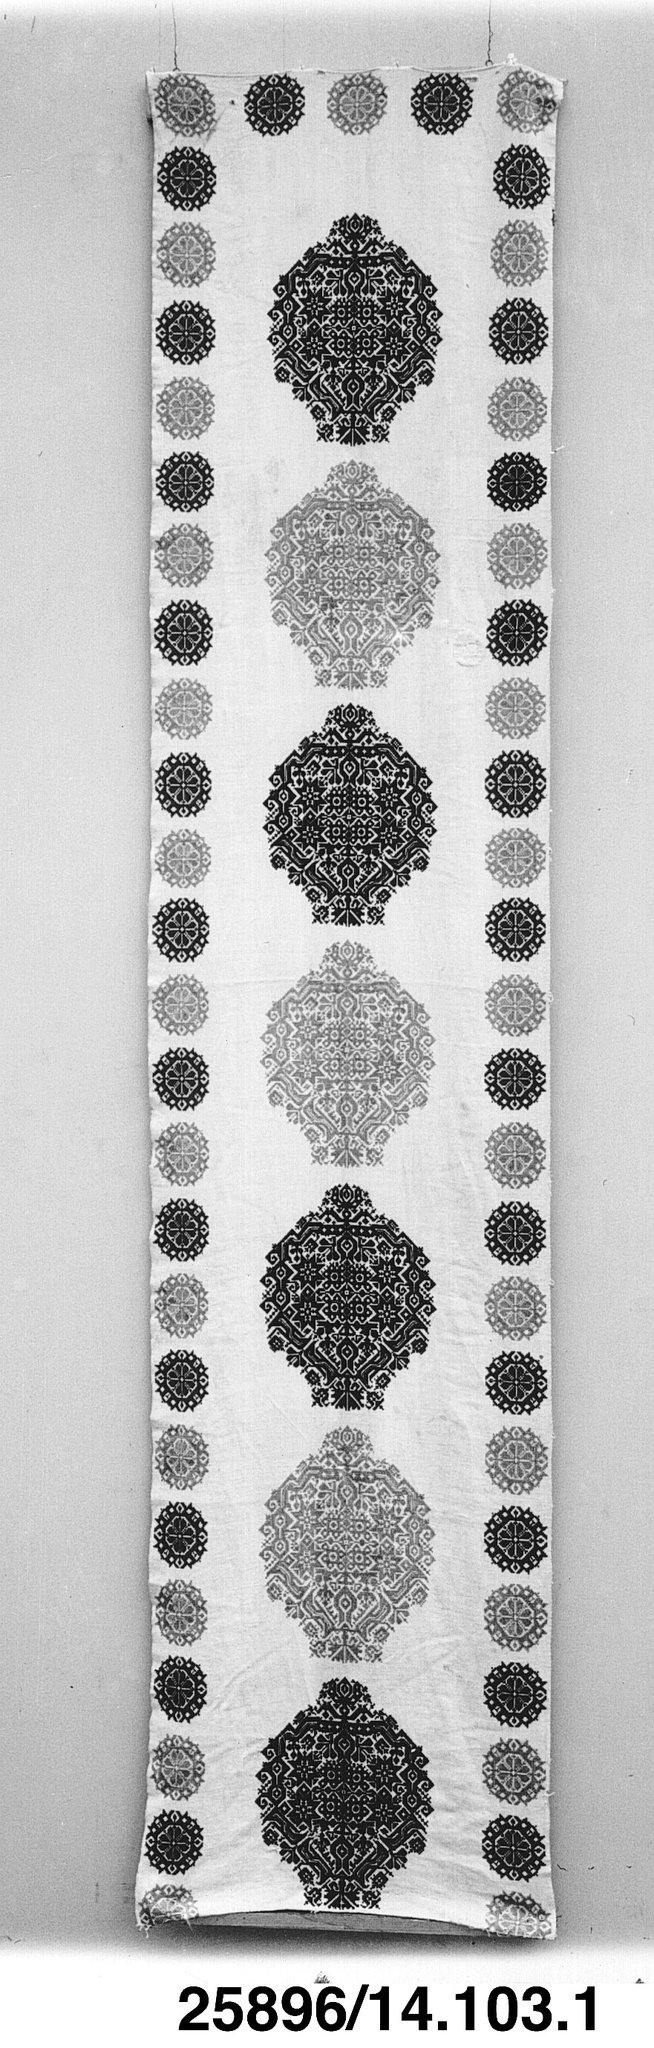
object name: bed valance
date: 1701-1800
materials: linen, silk